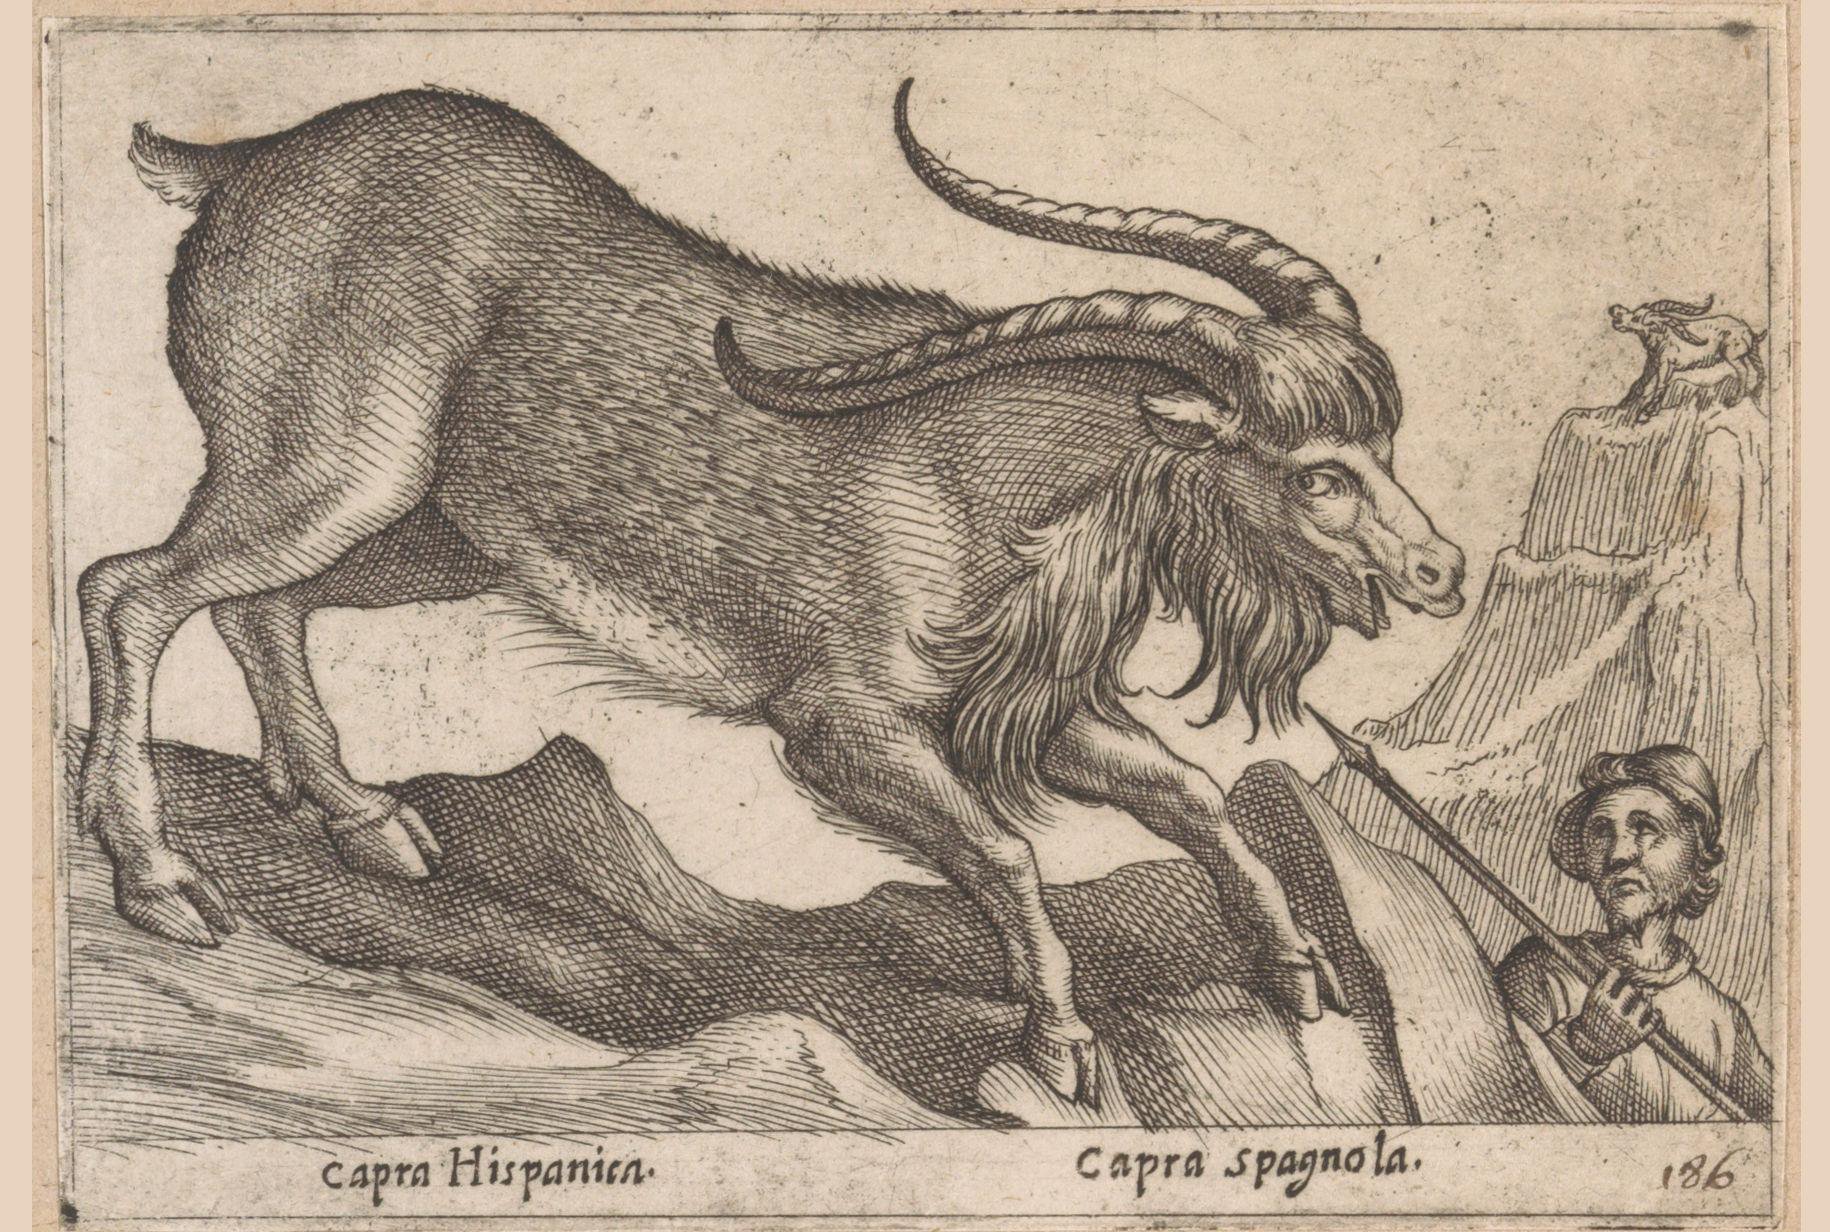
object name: print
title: Capra Hispanica/ Capra Spagnola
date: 1565-1630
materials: paper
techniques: etching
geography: italy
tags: goat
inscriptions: number: ‘186’, collector's mark: Lugt 11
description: Deze prent maakt deel uit van een reeks prenten van dieren door Antonio Tempesta. Bekend is dat een tweede staat (met nummering) van deze serie is uitgegeven door Giovanni Giacomo de' Rossi in 1650. Onbekend is wie de eerste staat heeft uitgegeven en wanneer.